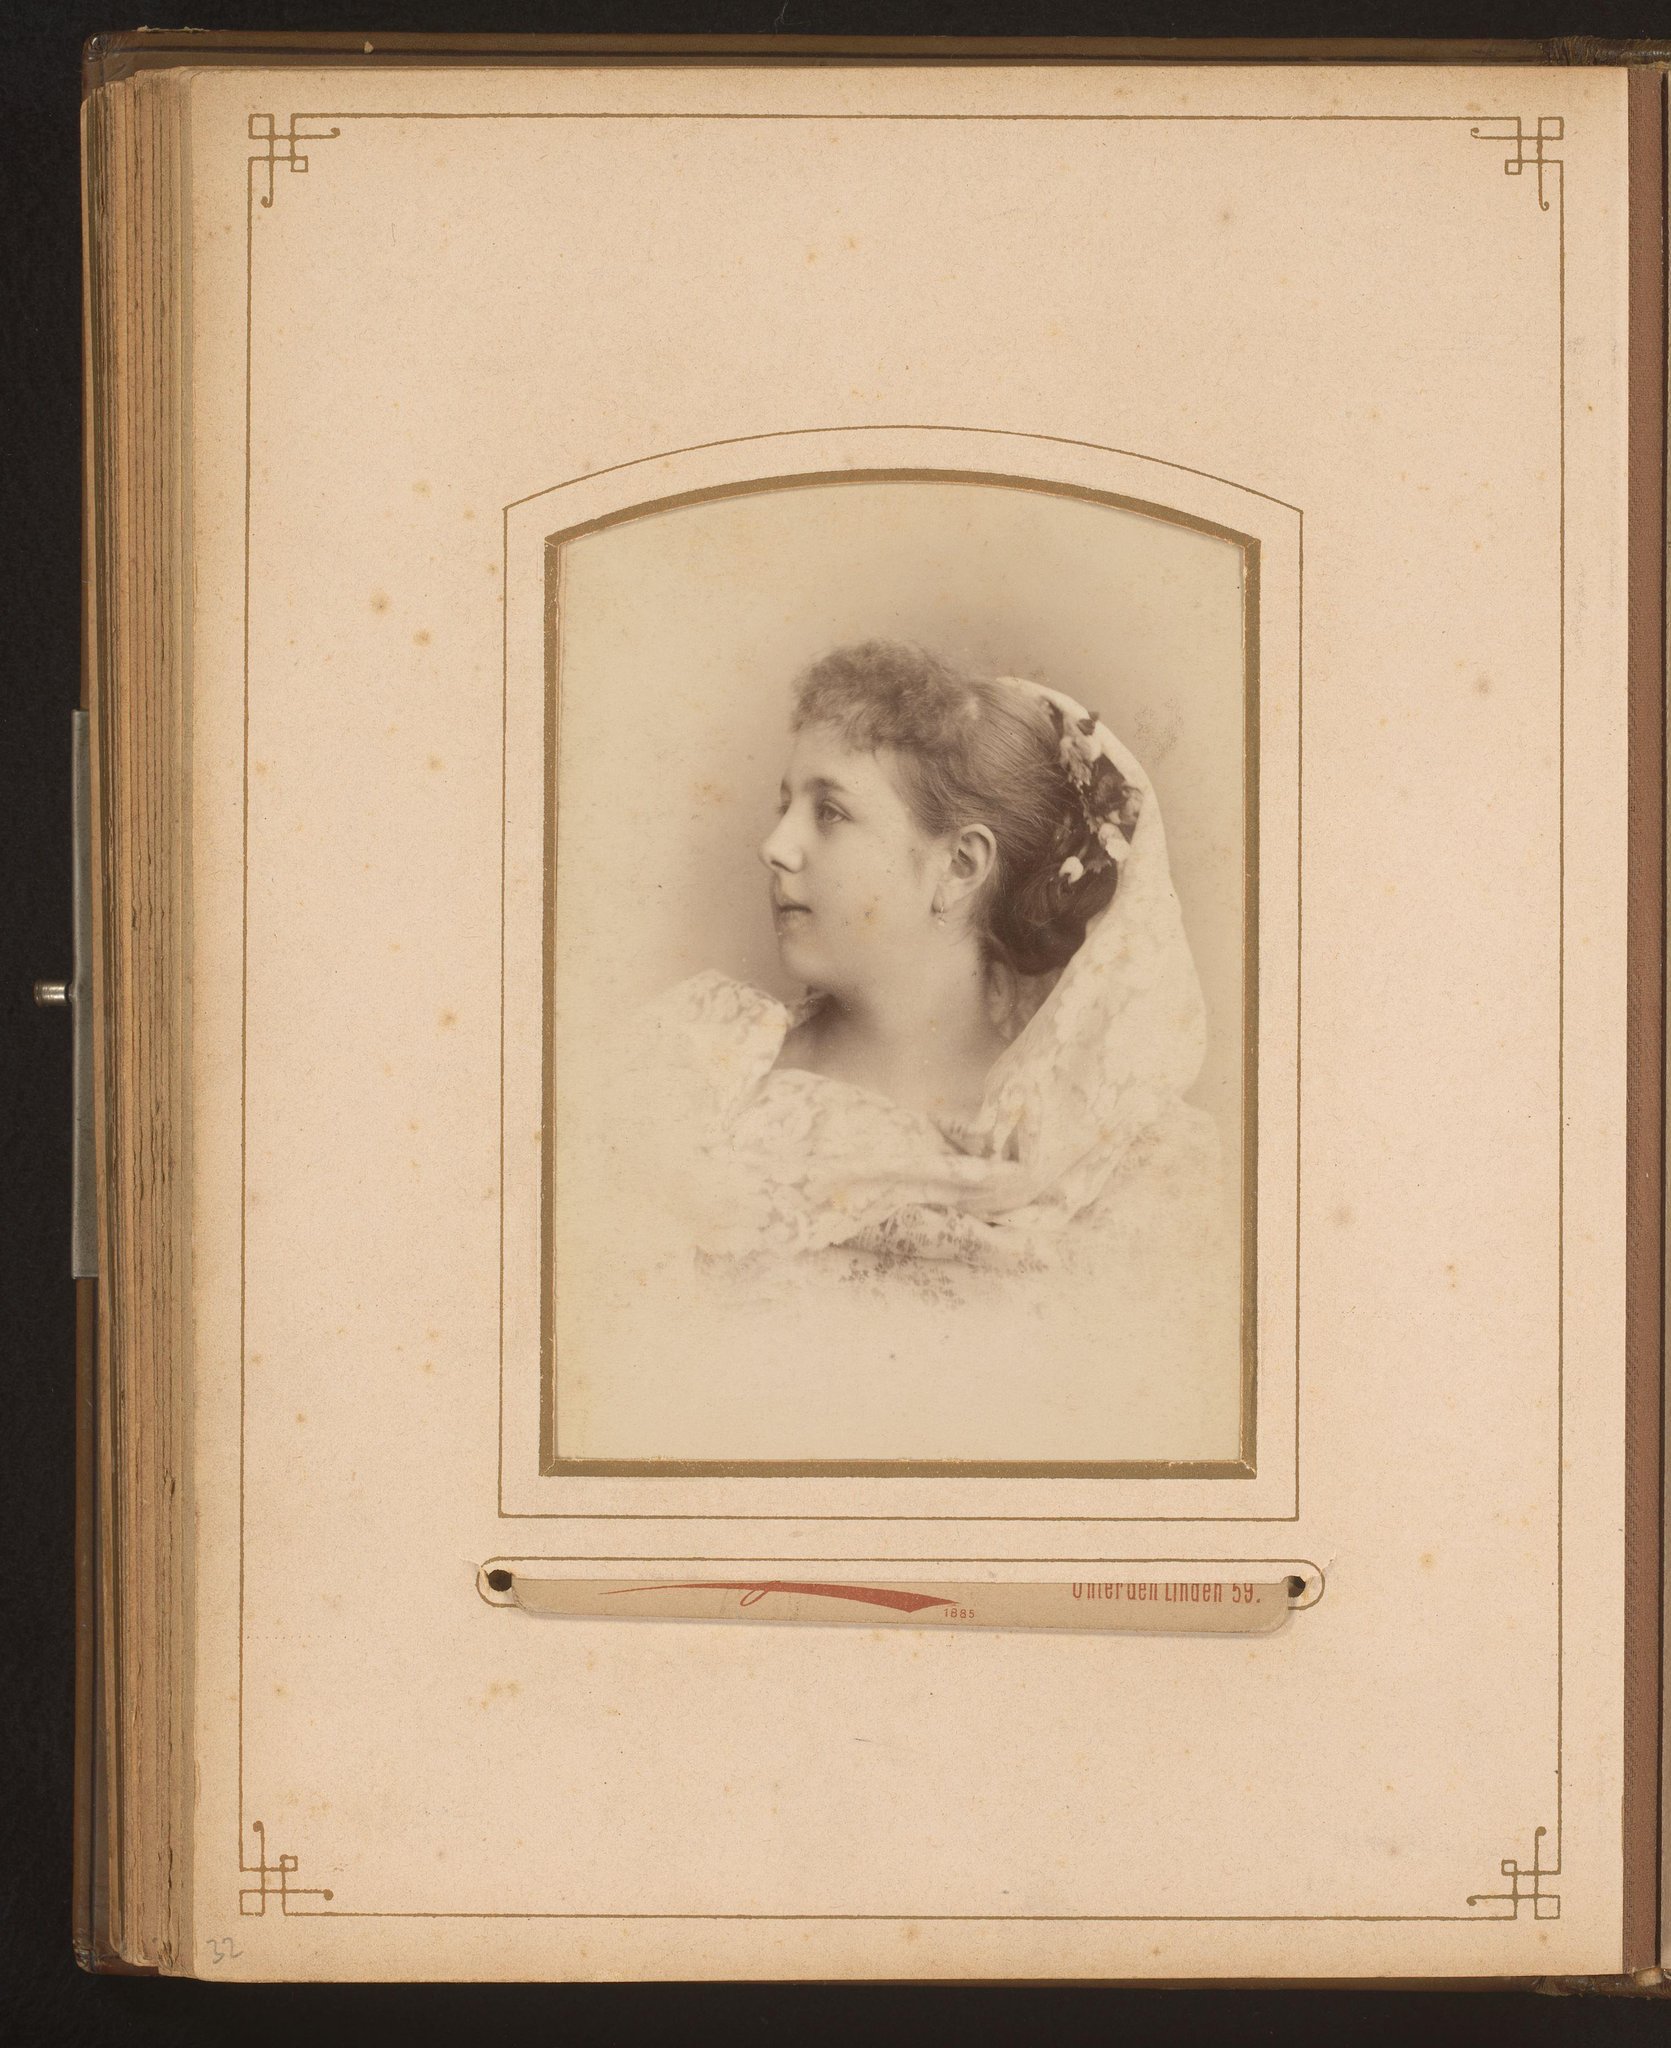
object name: album leaf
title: Portret van een vrouw in een witte jurk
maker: fritz leyde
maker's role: fotograaf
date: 1885-1899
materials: cardboard, photographic support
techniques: albumen print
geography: berlin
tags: historical persons - bb - woman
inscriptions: inscription: ‘Fritz Leyde & Co/ 1885/ Berlin, N.W./ Unter den Linden 59’